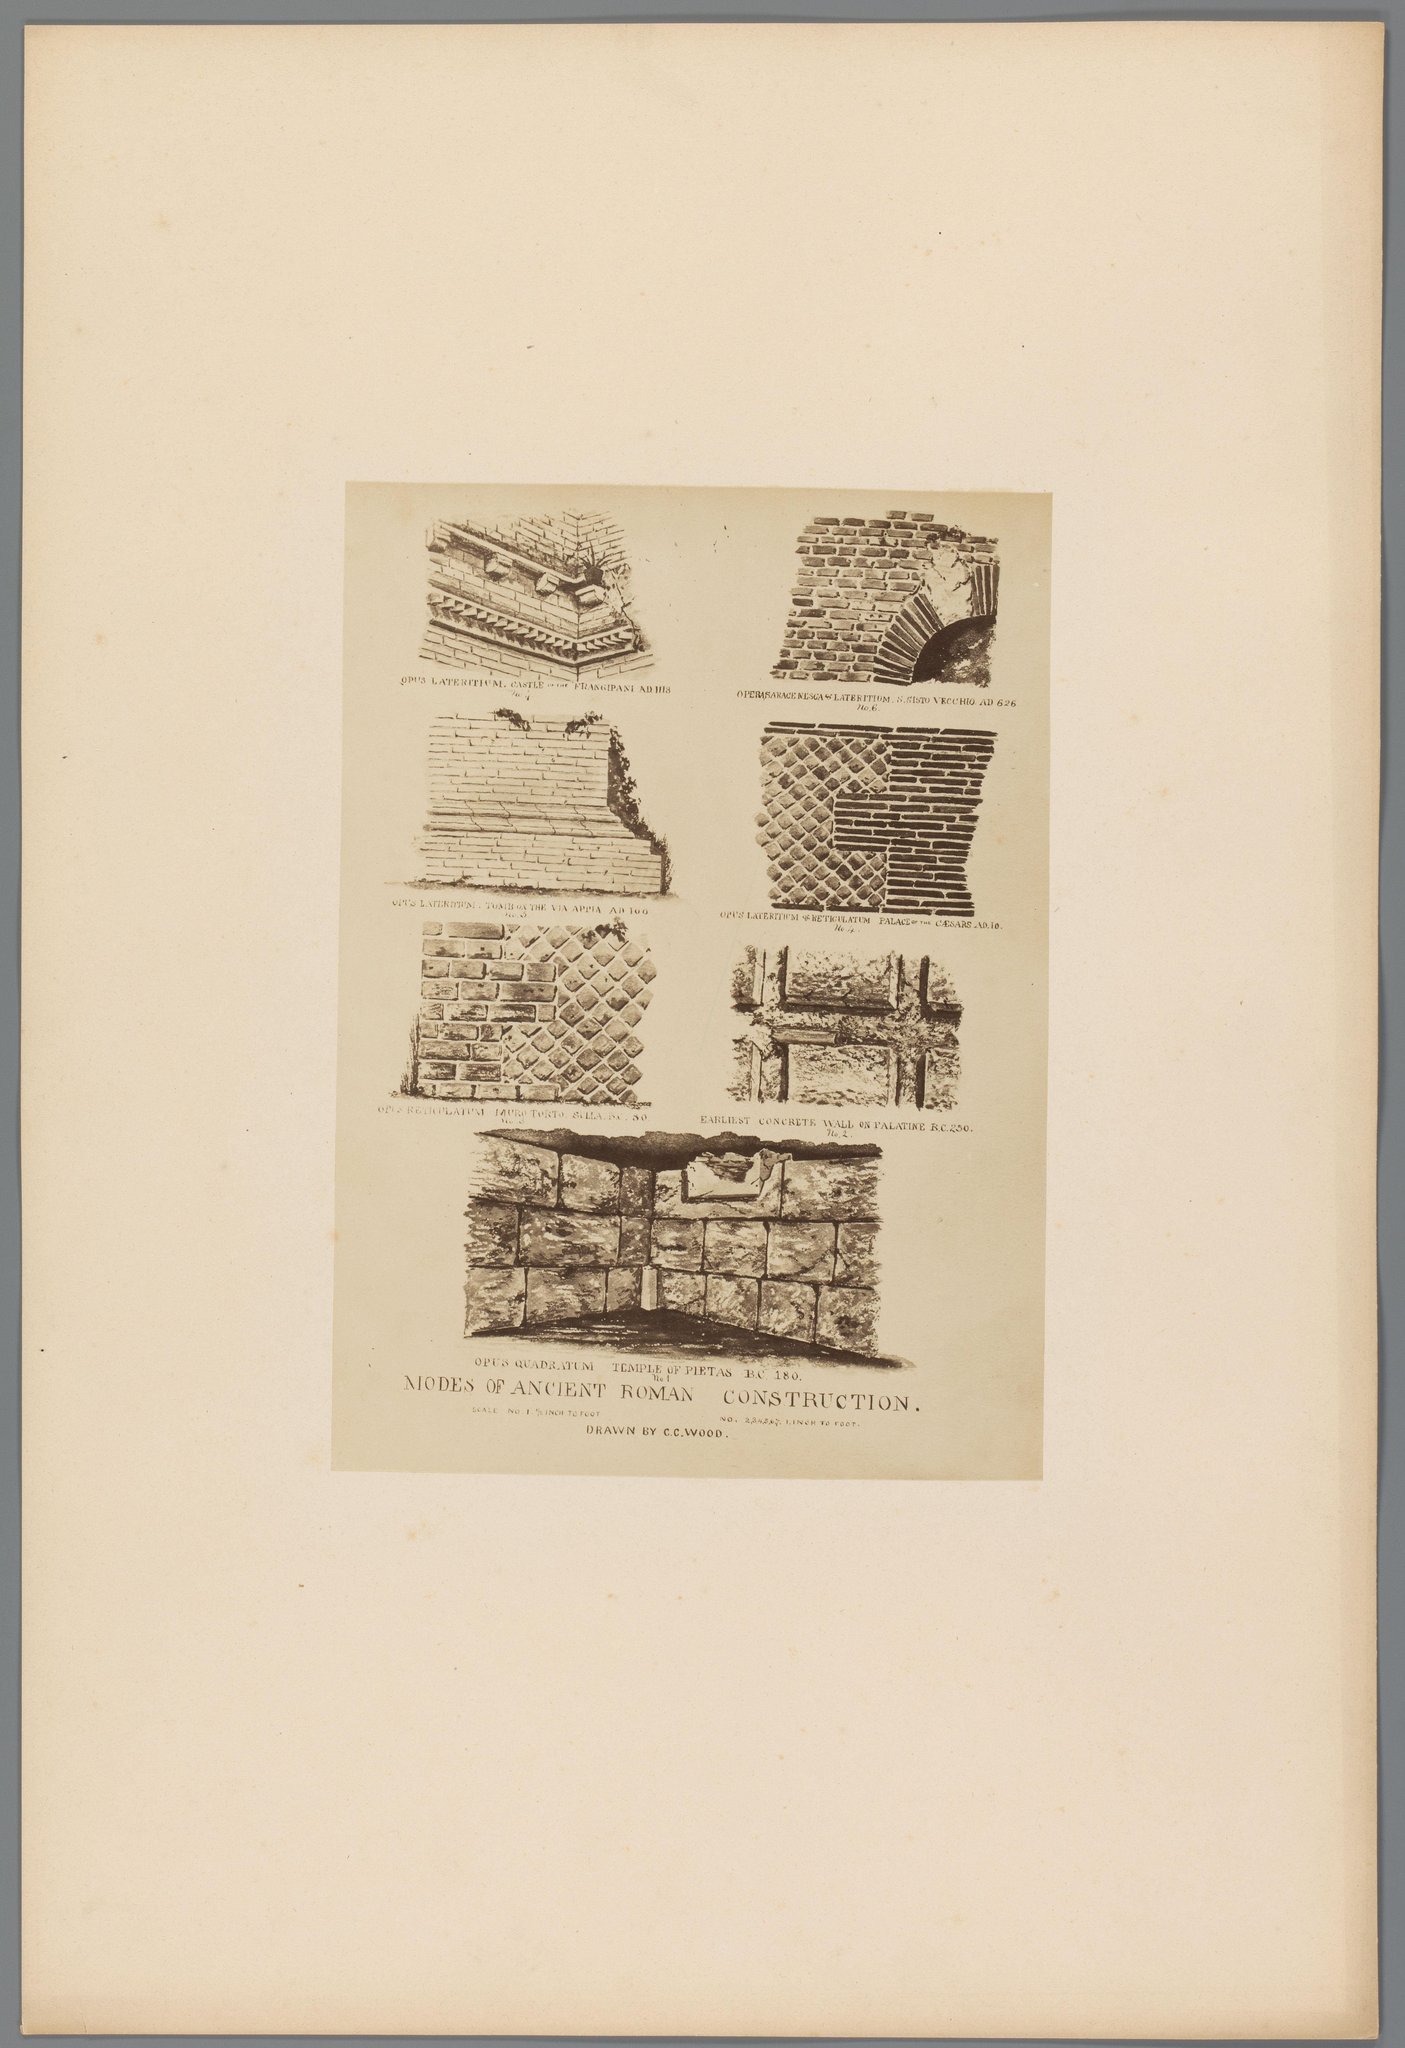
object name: reproduction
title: Fotoreproductie van een tekening met Romeinse steenverbanden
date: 1851-1900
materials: cardboard, paper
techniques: albumen print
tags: drawing, stone ~ building material